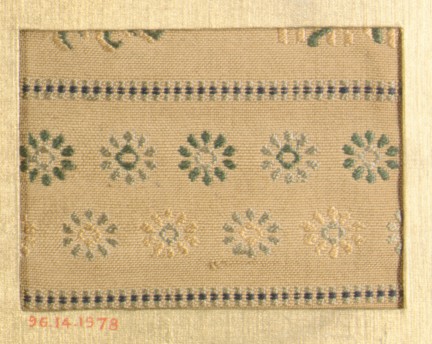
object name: piece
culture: japanese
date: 1701-1900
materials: silk